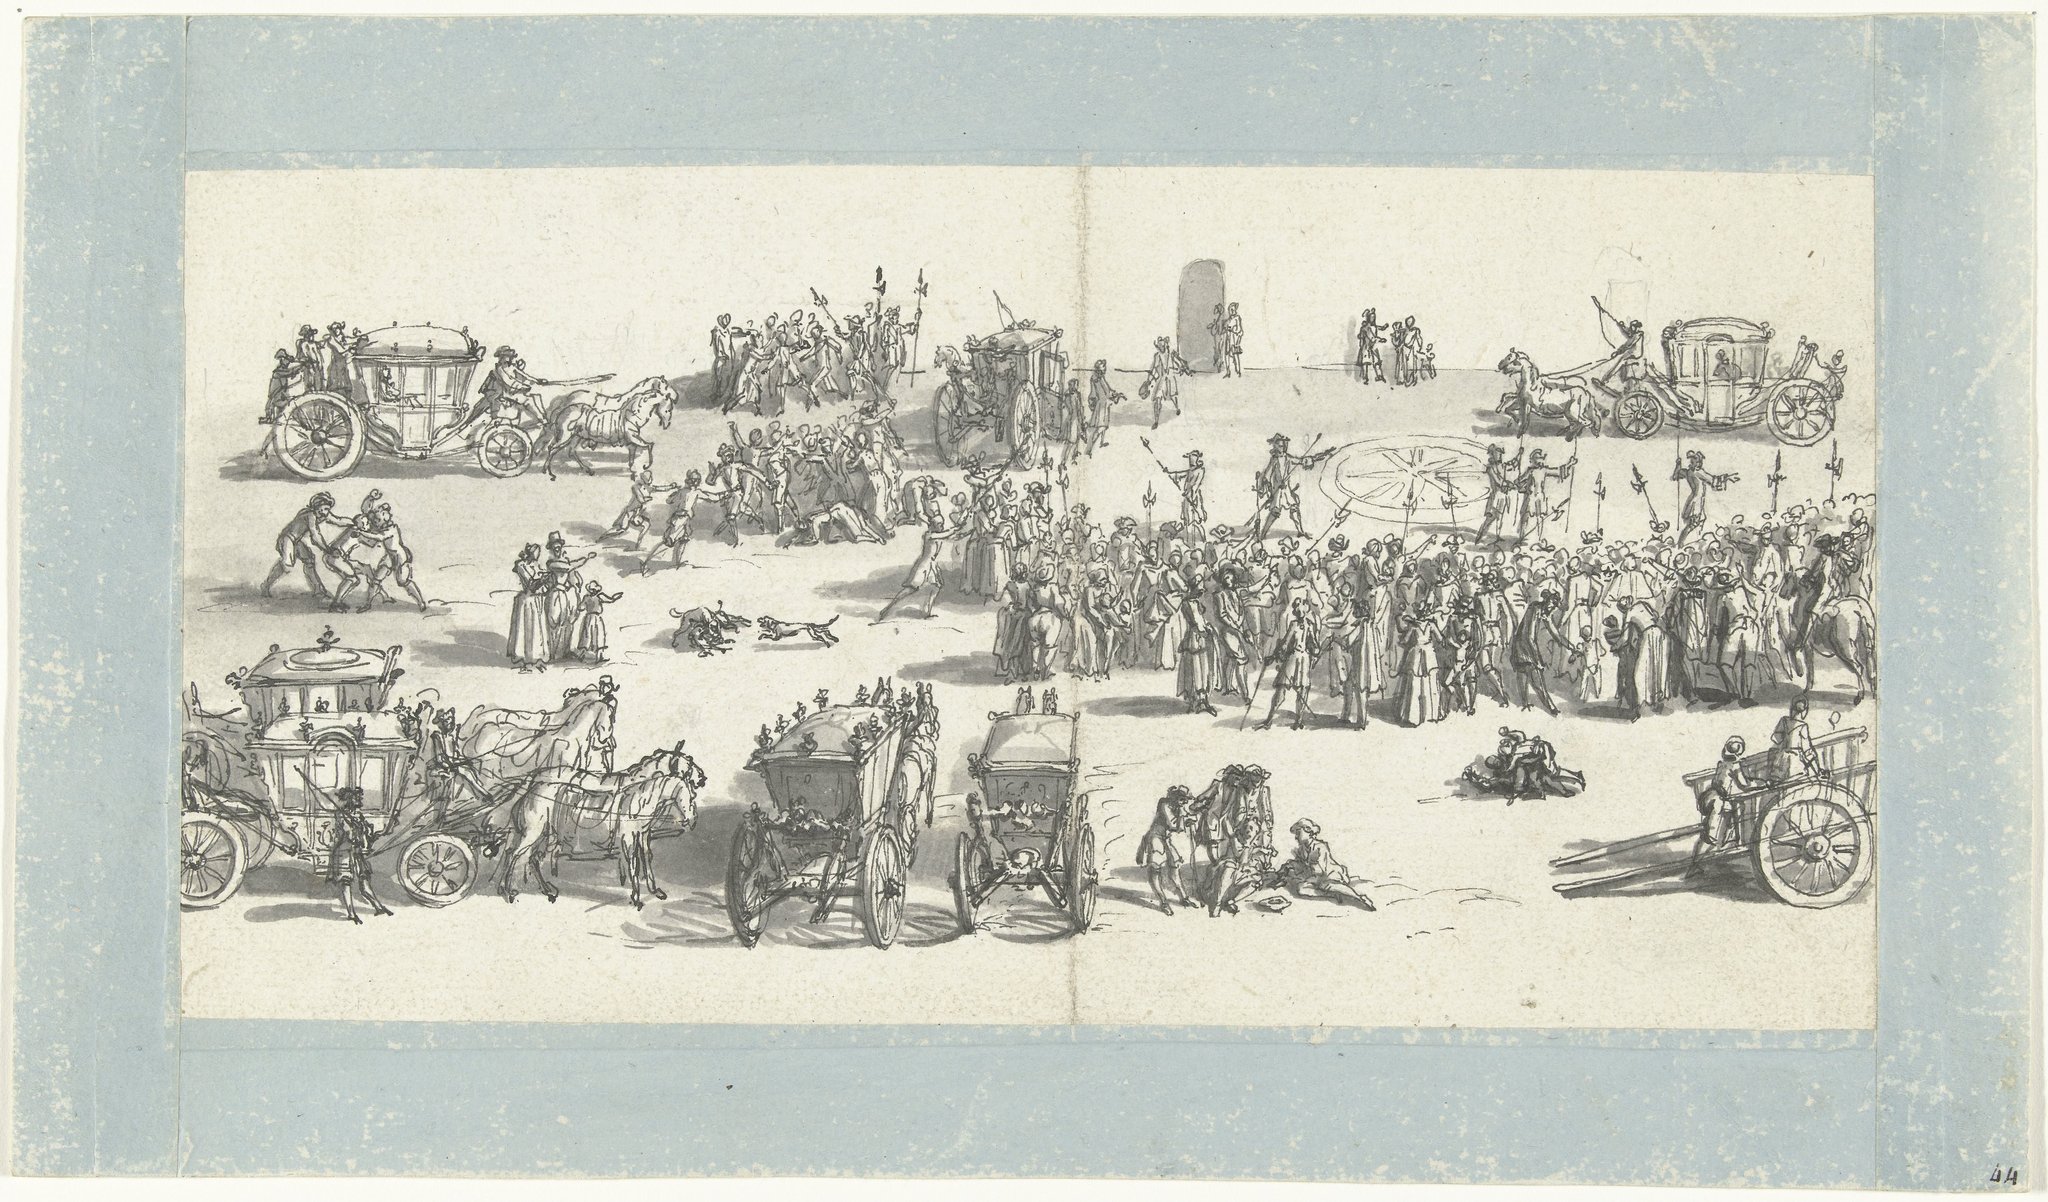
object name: drawing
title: Menigte en karossen op een plein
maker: bernard picart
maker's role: draughtsman, print maker, publisher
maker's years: 1673-1733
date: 1683-1733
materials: ink, paper, pencil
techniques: brush, pen